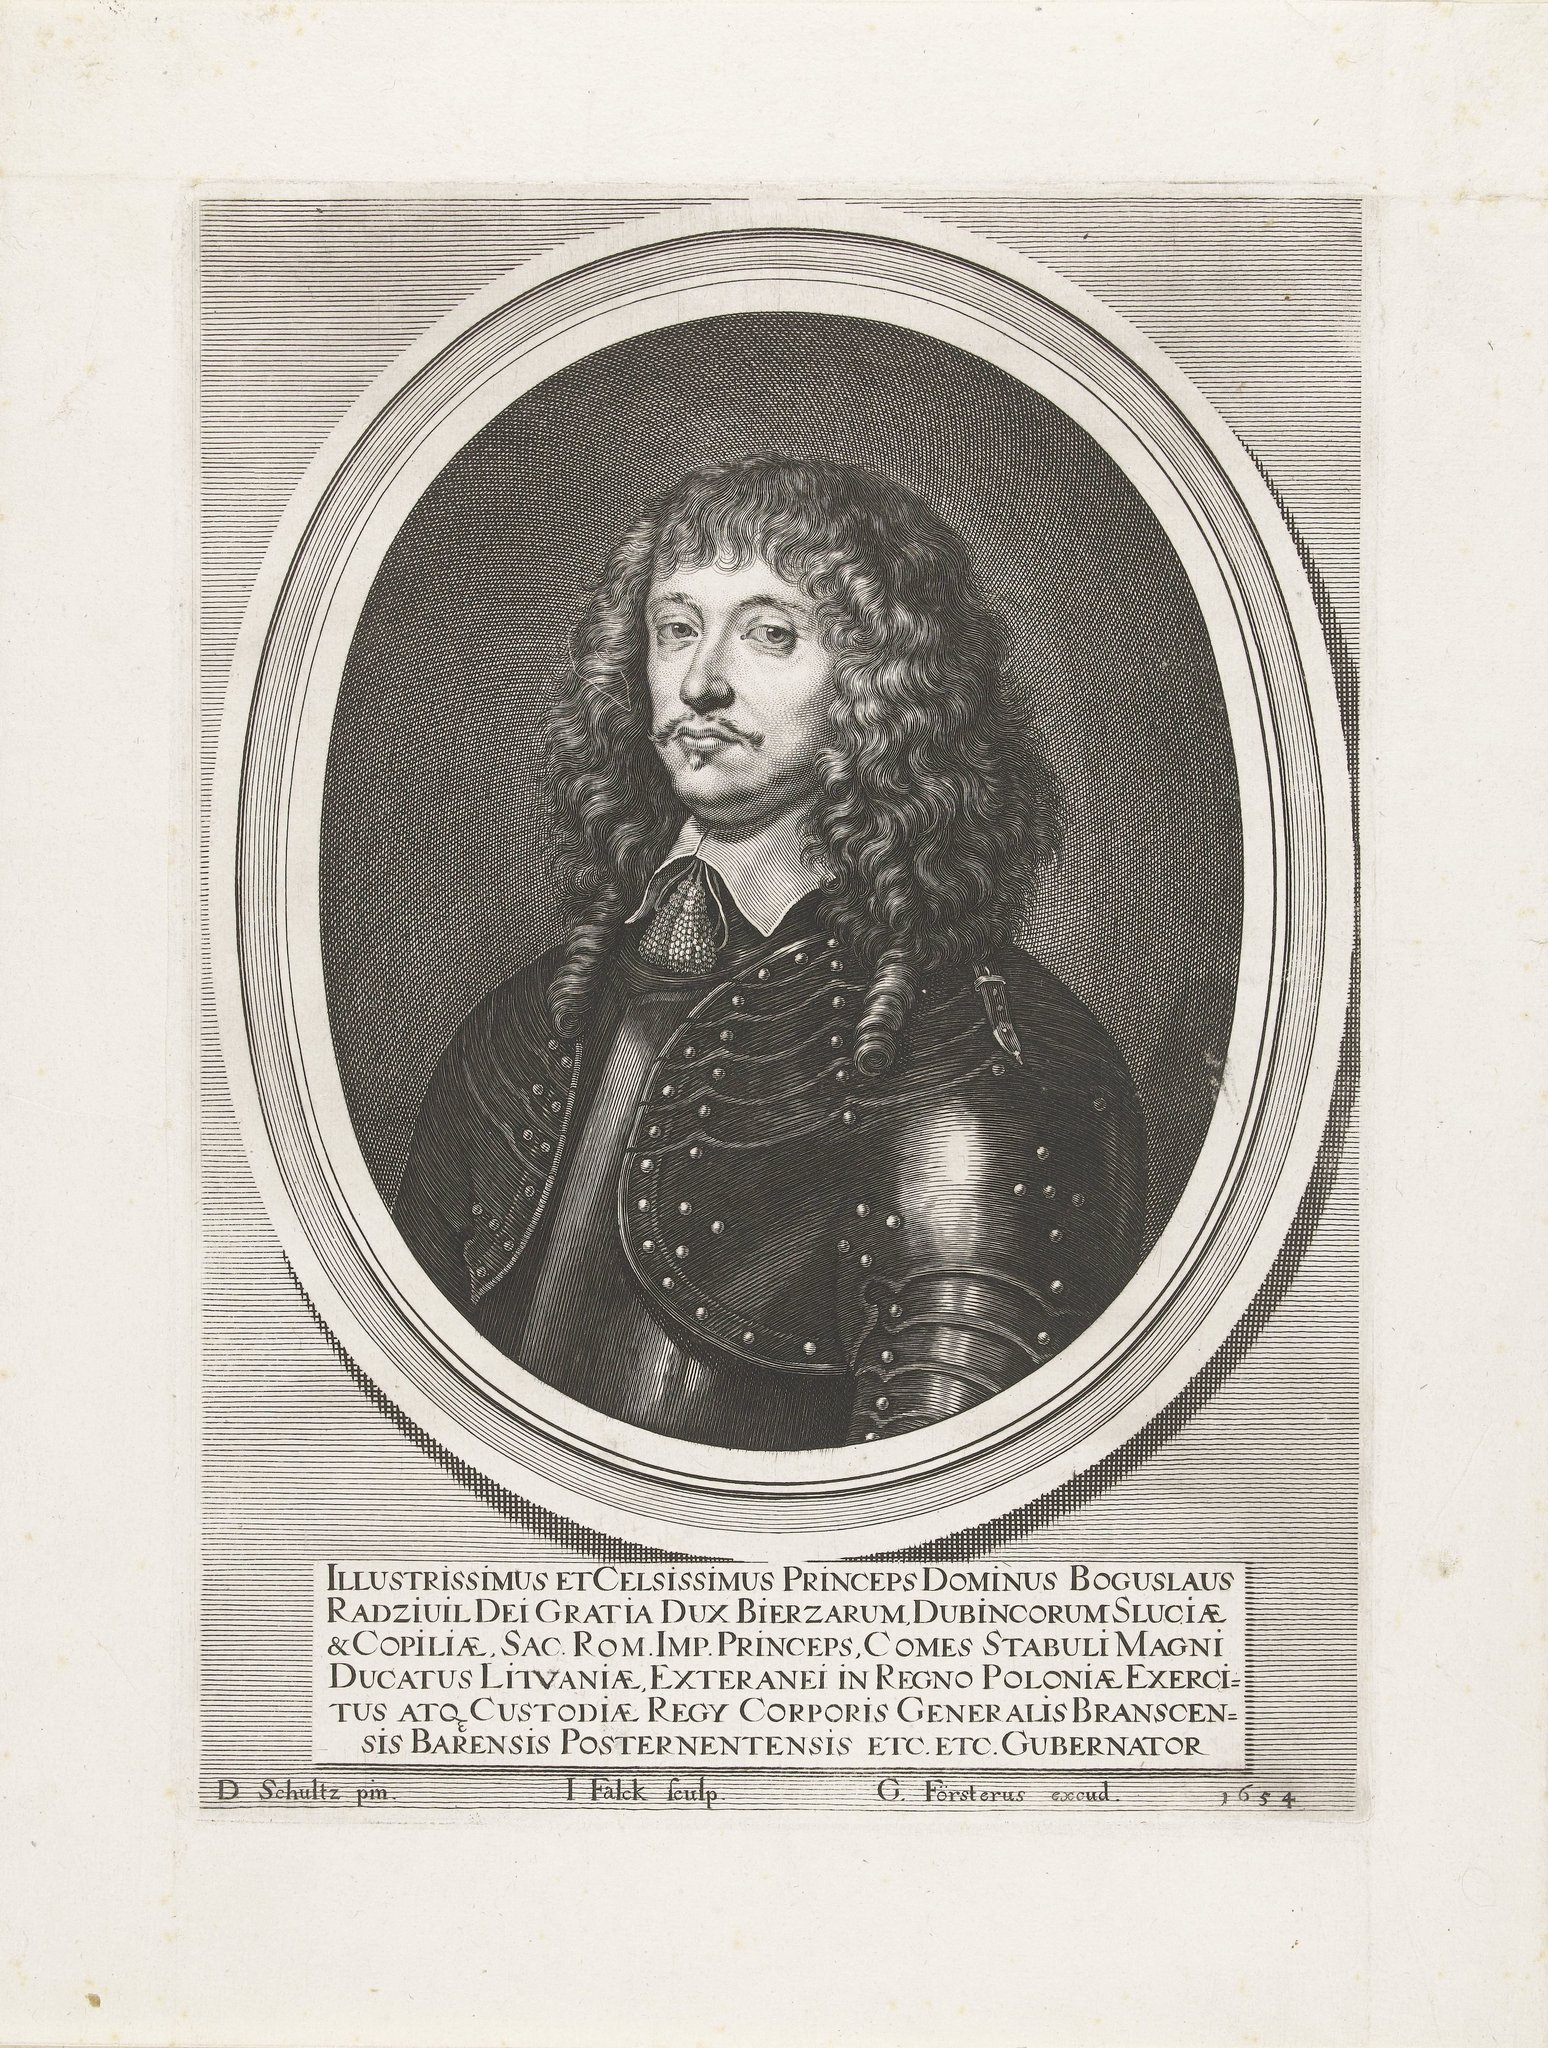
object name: print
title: Portret van Boguslaw Radziwill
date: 1654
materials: paper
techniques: engraving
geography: stockholm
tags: danzig, königsberg, prins, boguslaw radziwill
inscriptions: collector's mark: Lugt 240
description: Busteportret van prins Boguslaw Radziwill, in harnas. Afgebeeld in ovale omlijsting met onderschrift in Latijn.